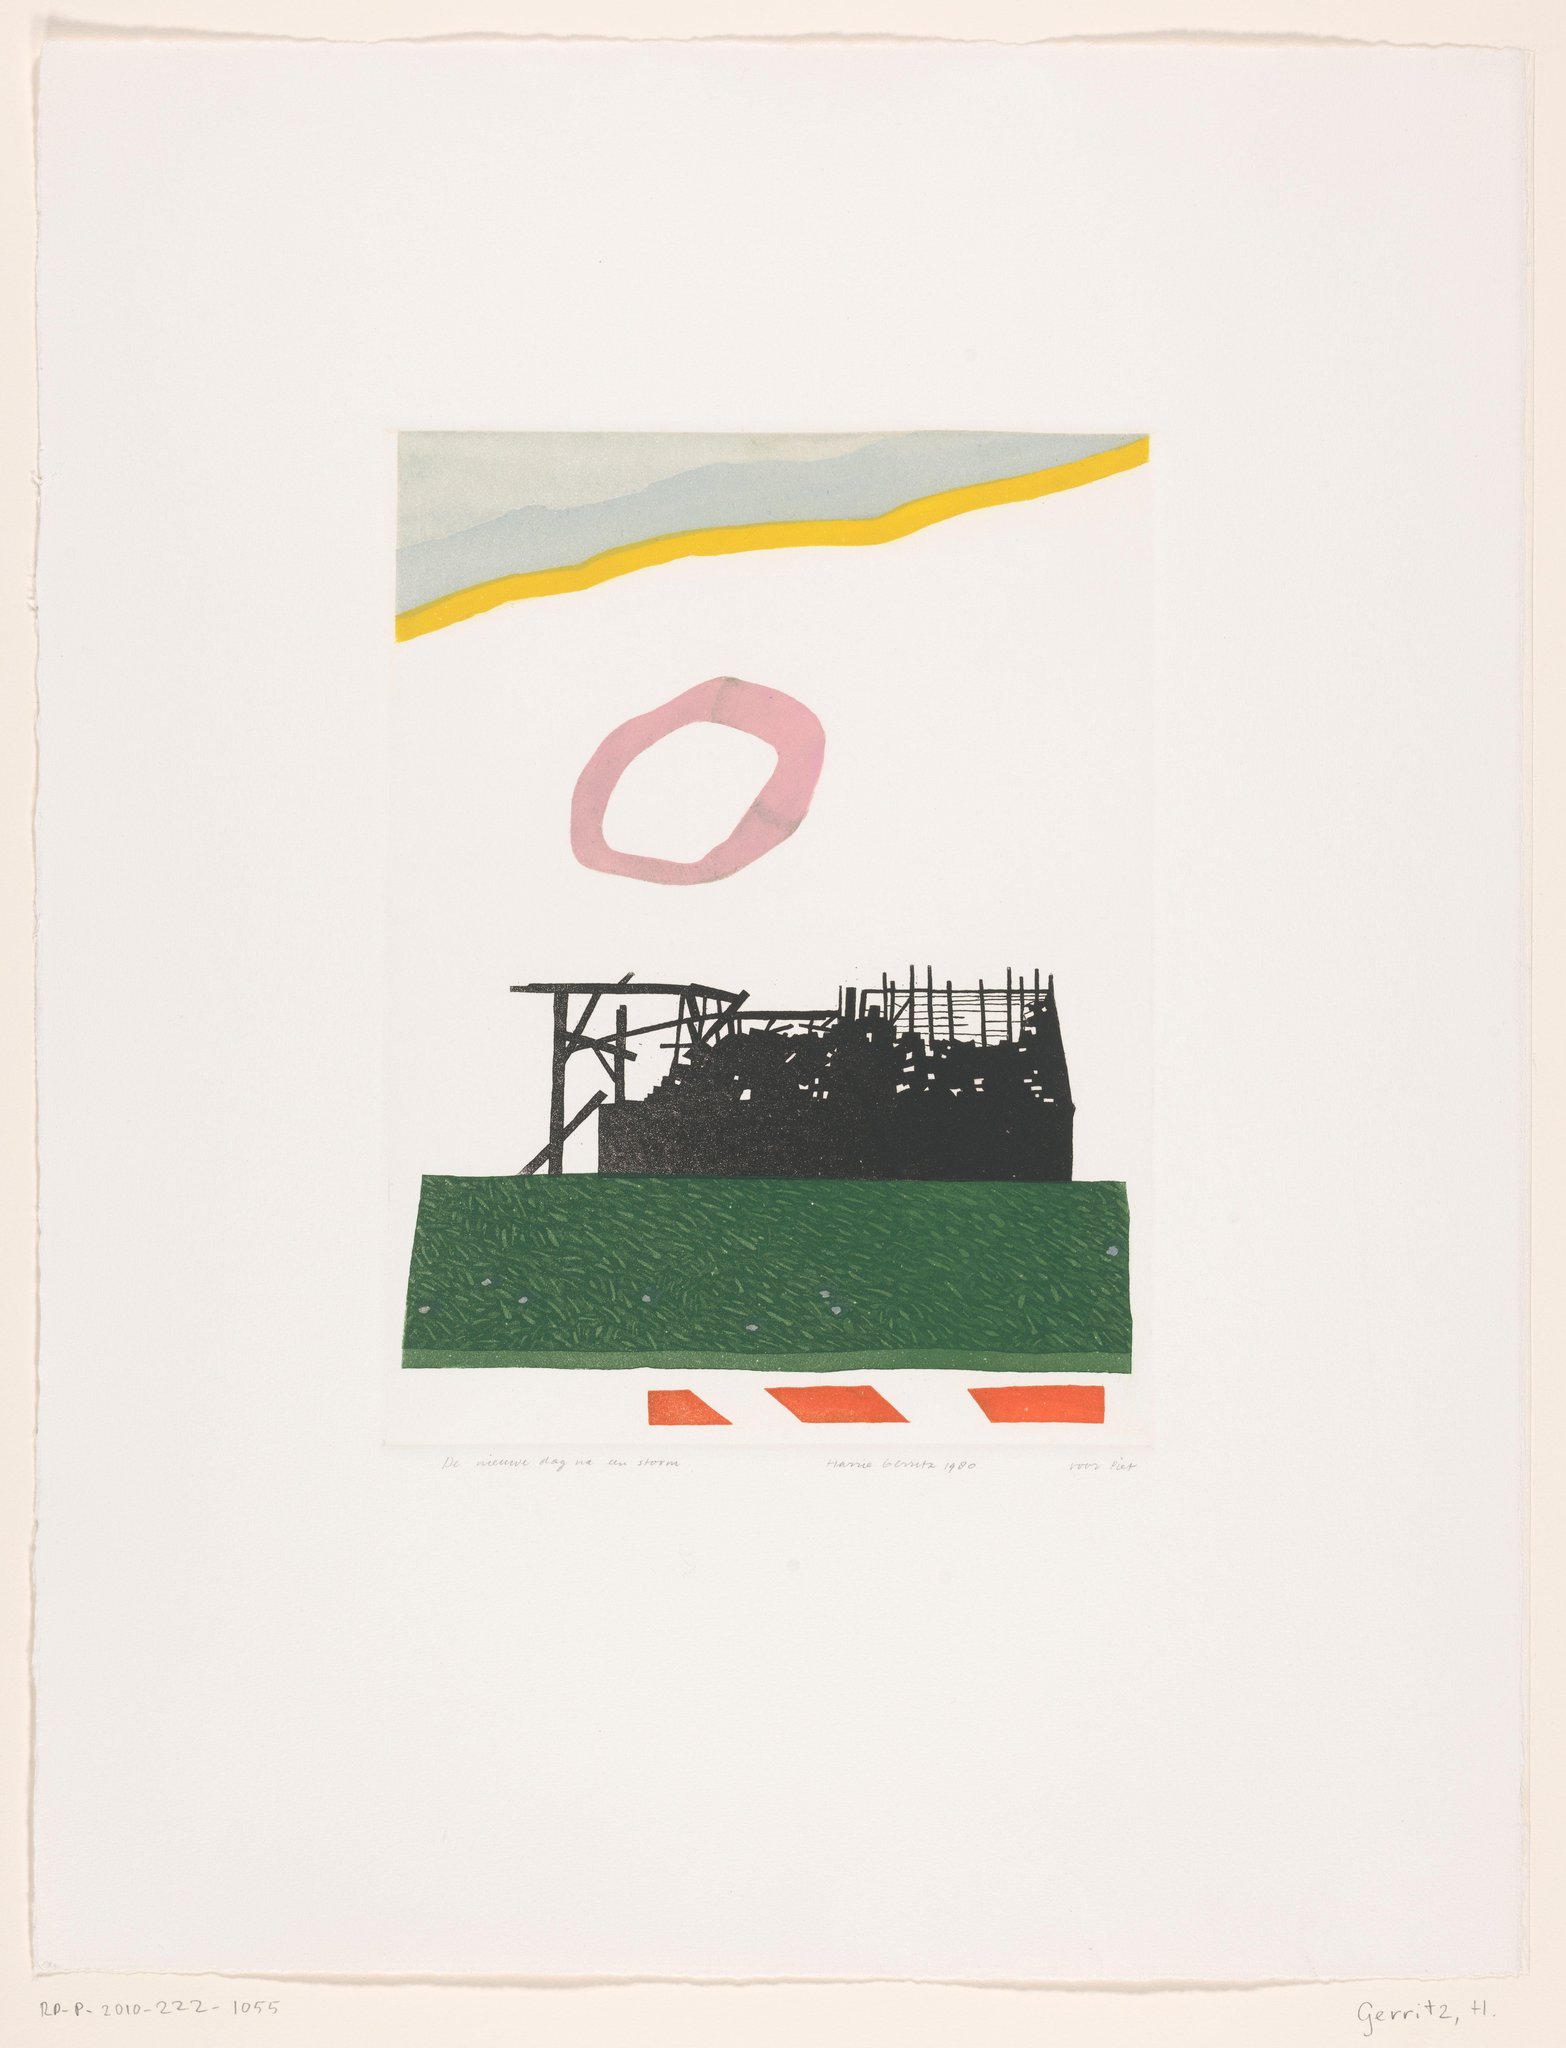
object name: print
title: De nieuwe dag na een storm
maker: harrie a. gerritz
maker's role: draughtsman, painter, print maker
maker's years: 1940-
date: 1980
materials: paper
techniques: aquatint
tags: landscapes in the temperate zone, housing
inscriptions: dedication: ‘voor Piet’, collector's mark: Lugt 2228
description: Zwart geraamte van een gebouw afstekend tegen een witte lucht met daarin een roze zon.